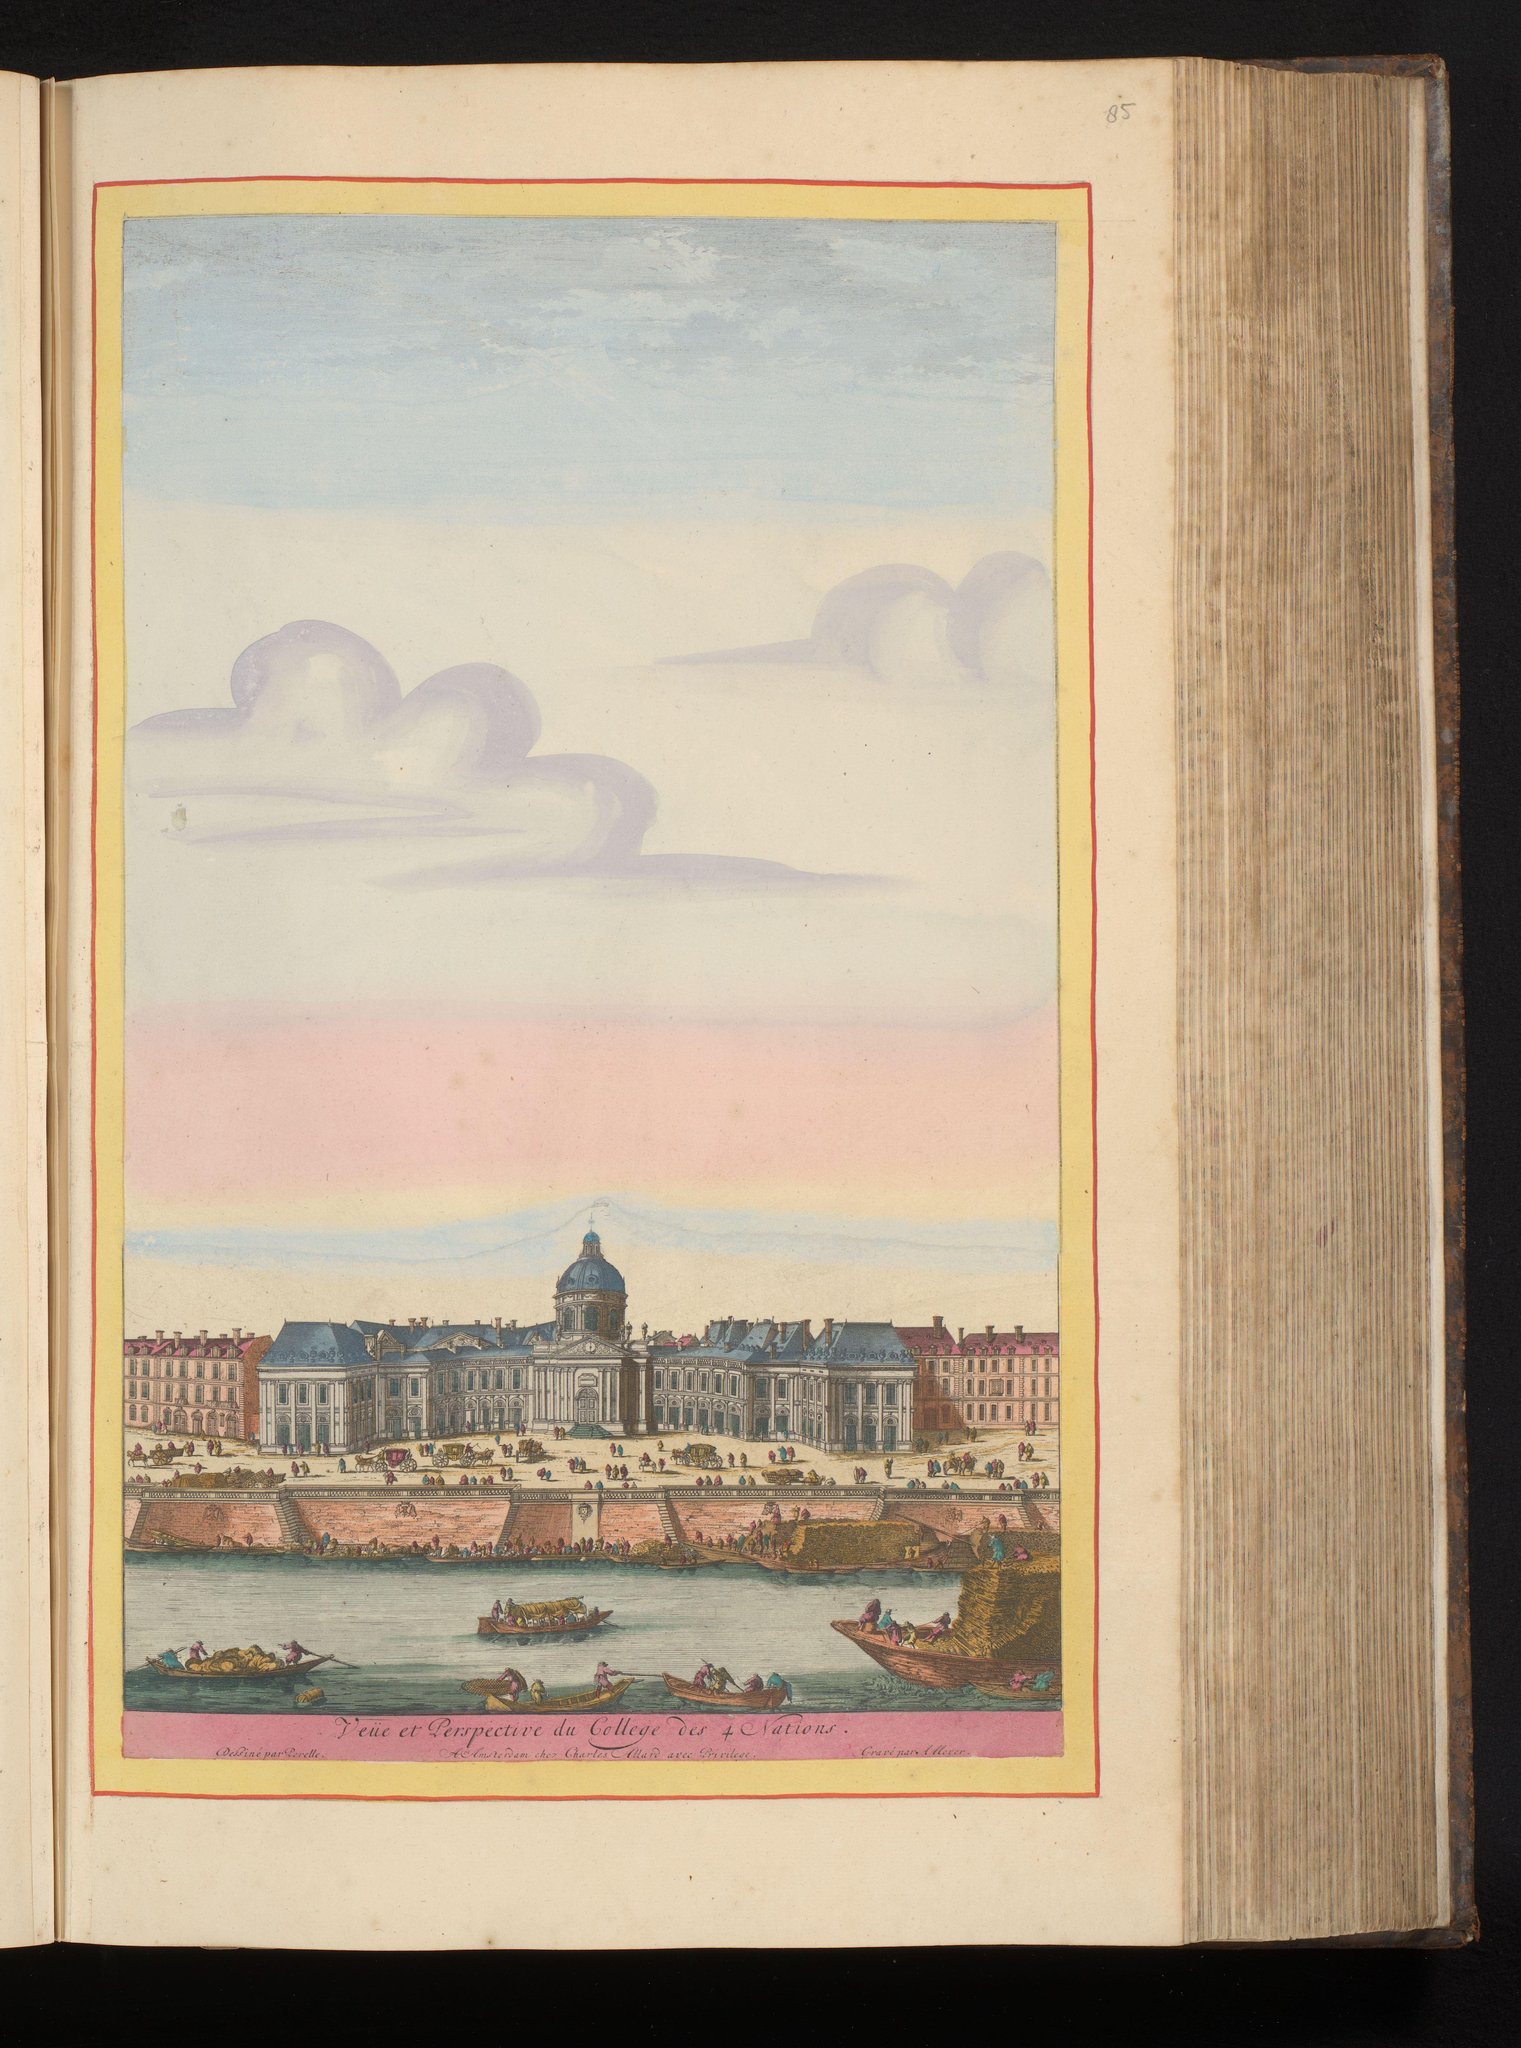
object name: album leaf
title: Veüe et Perspective du College des 4 Nations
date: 1685-1695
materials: paper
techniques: etching, hand coloring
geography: paris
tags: palace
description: De prent is langs de bovenrand van de voorstelling afgescheurd. Het bovenste gedeelte is hoger opgeplakt, zodat de lucht hoger is geworden en het formaat van de voorstelling past bij de andere groot formaatvoorstellingen in het album.